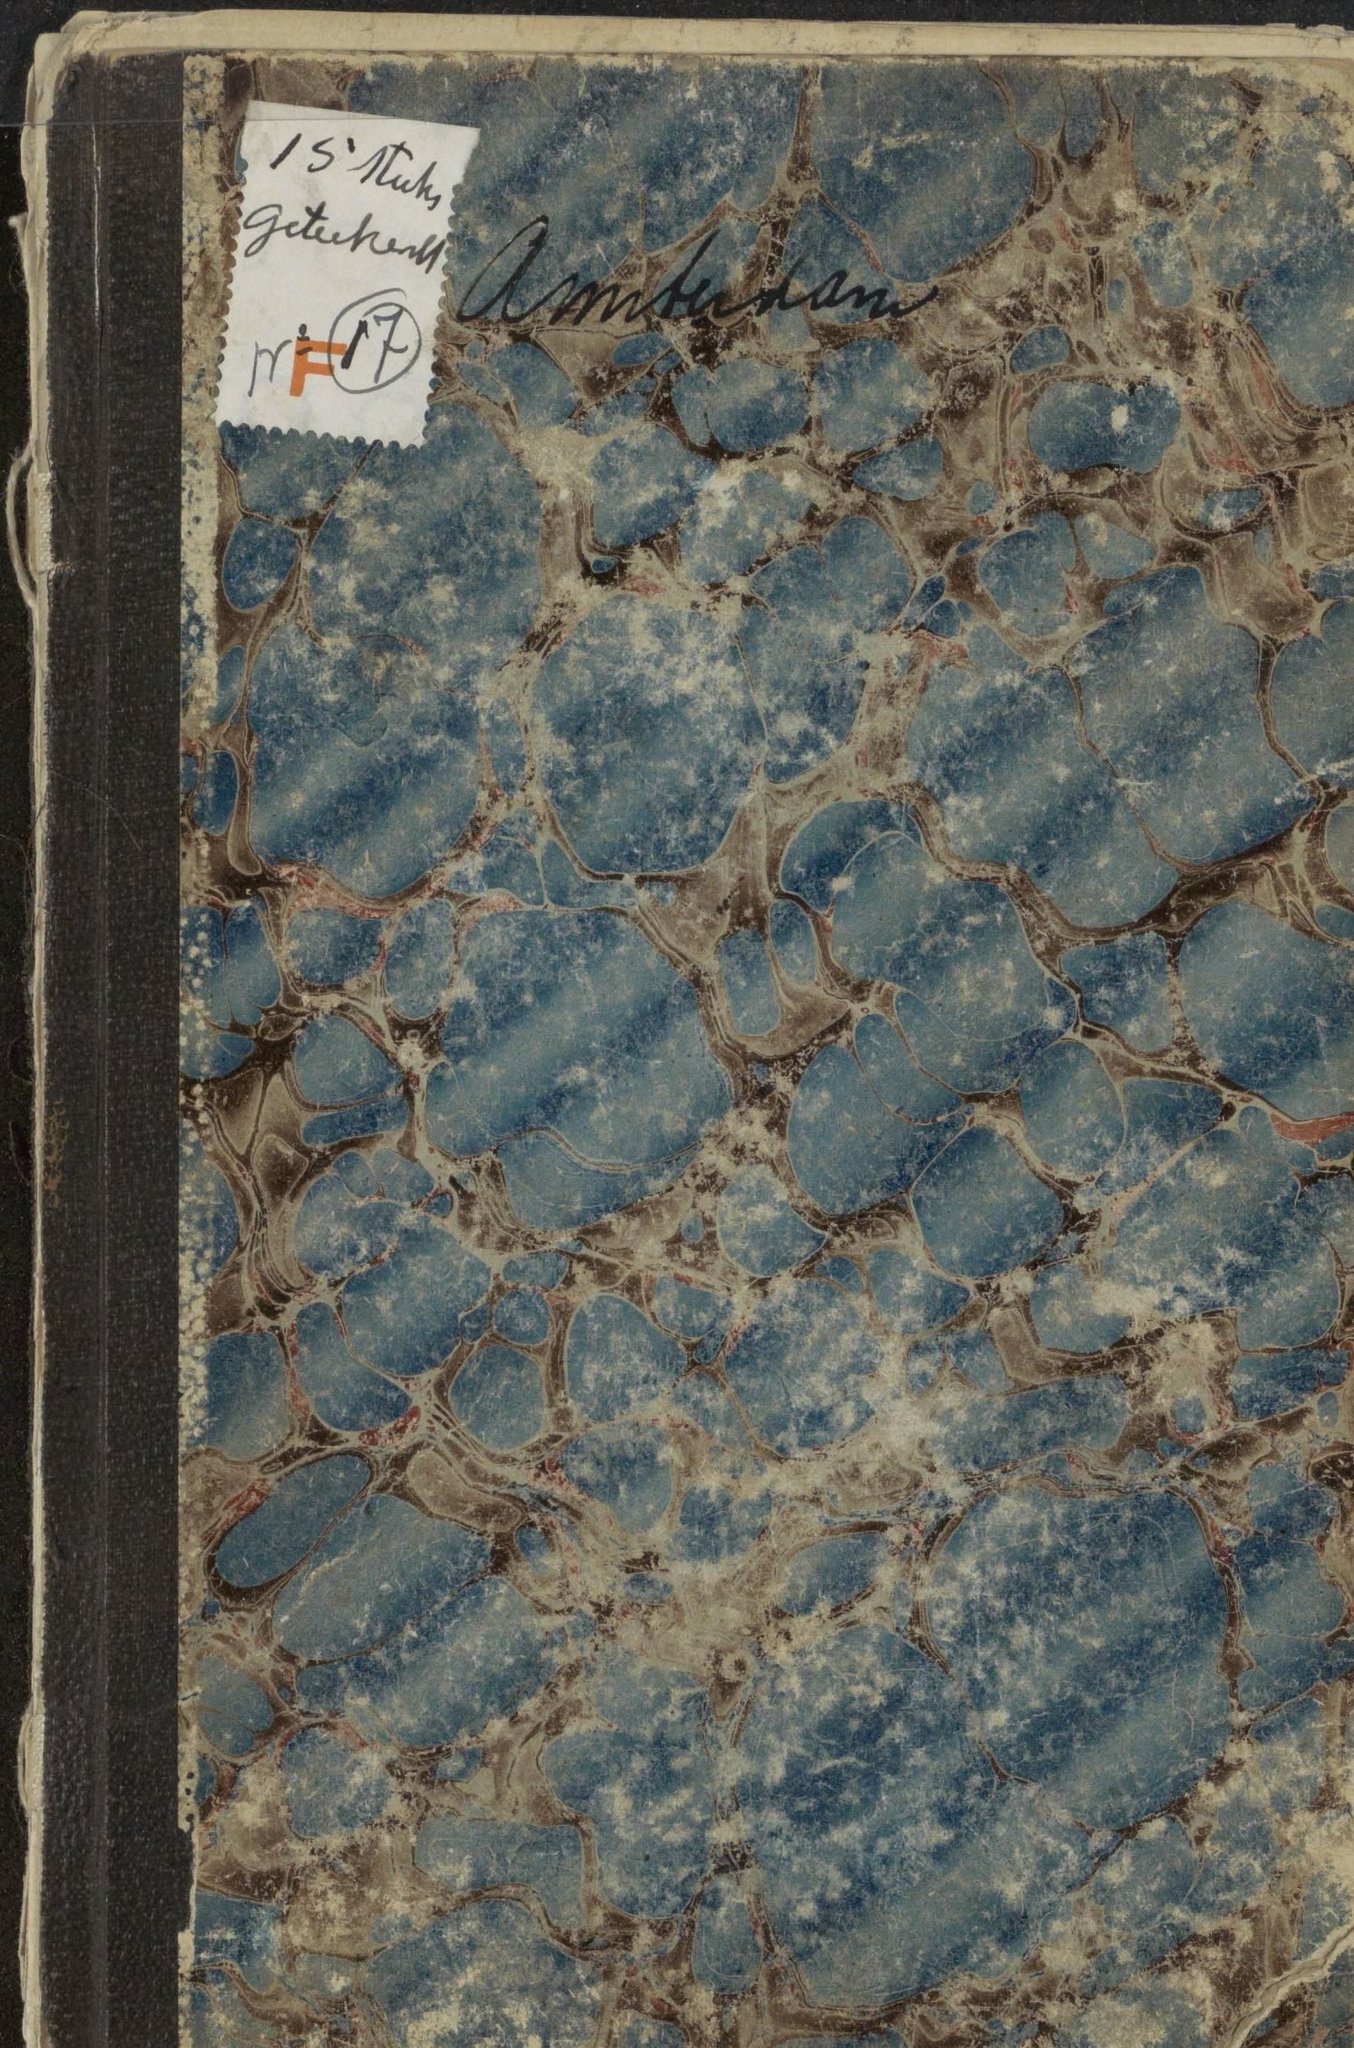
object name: sketchbook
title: Schetsboek met 19 bladen en 9 losse tekeningen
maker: george hendrik breitner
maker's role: draughtsman, painter, print maker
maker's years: 1857-1923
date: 1886-1923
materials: cardboard, chalk, ink, linen, paper, pencil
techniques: marbling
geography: amsterdam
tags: city-view, and landscape with man-made constructions, civic architecture; edifices; dwellings, street, amsterdam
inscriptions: annotation: ‘15 stuks/ geteekend/ 17/ Amsterdam’, collector's mark: Lugt 2228, workshop stamp: Lugt 291d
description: Schetsboek met 19 bladen en 9 losse kleinere bladen met stadsgezichten, duinlandschappen en figuurstudies.